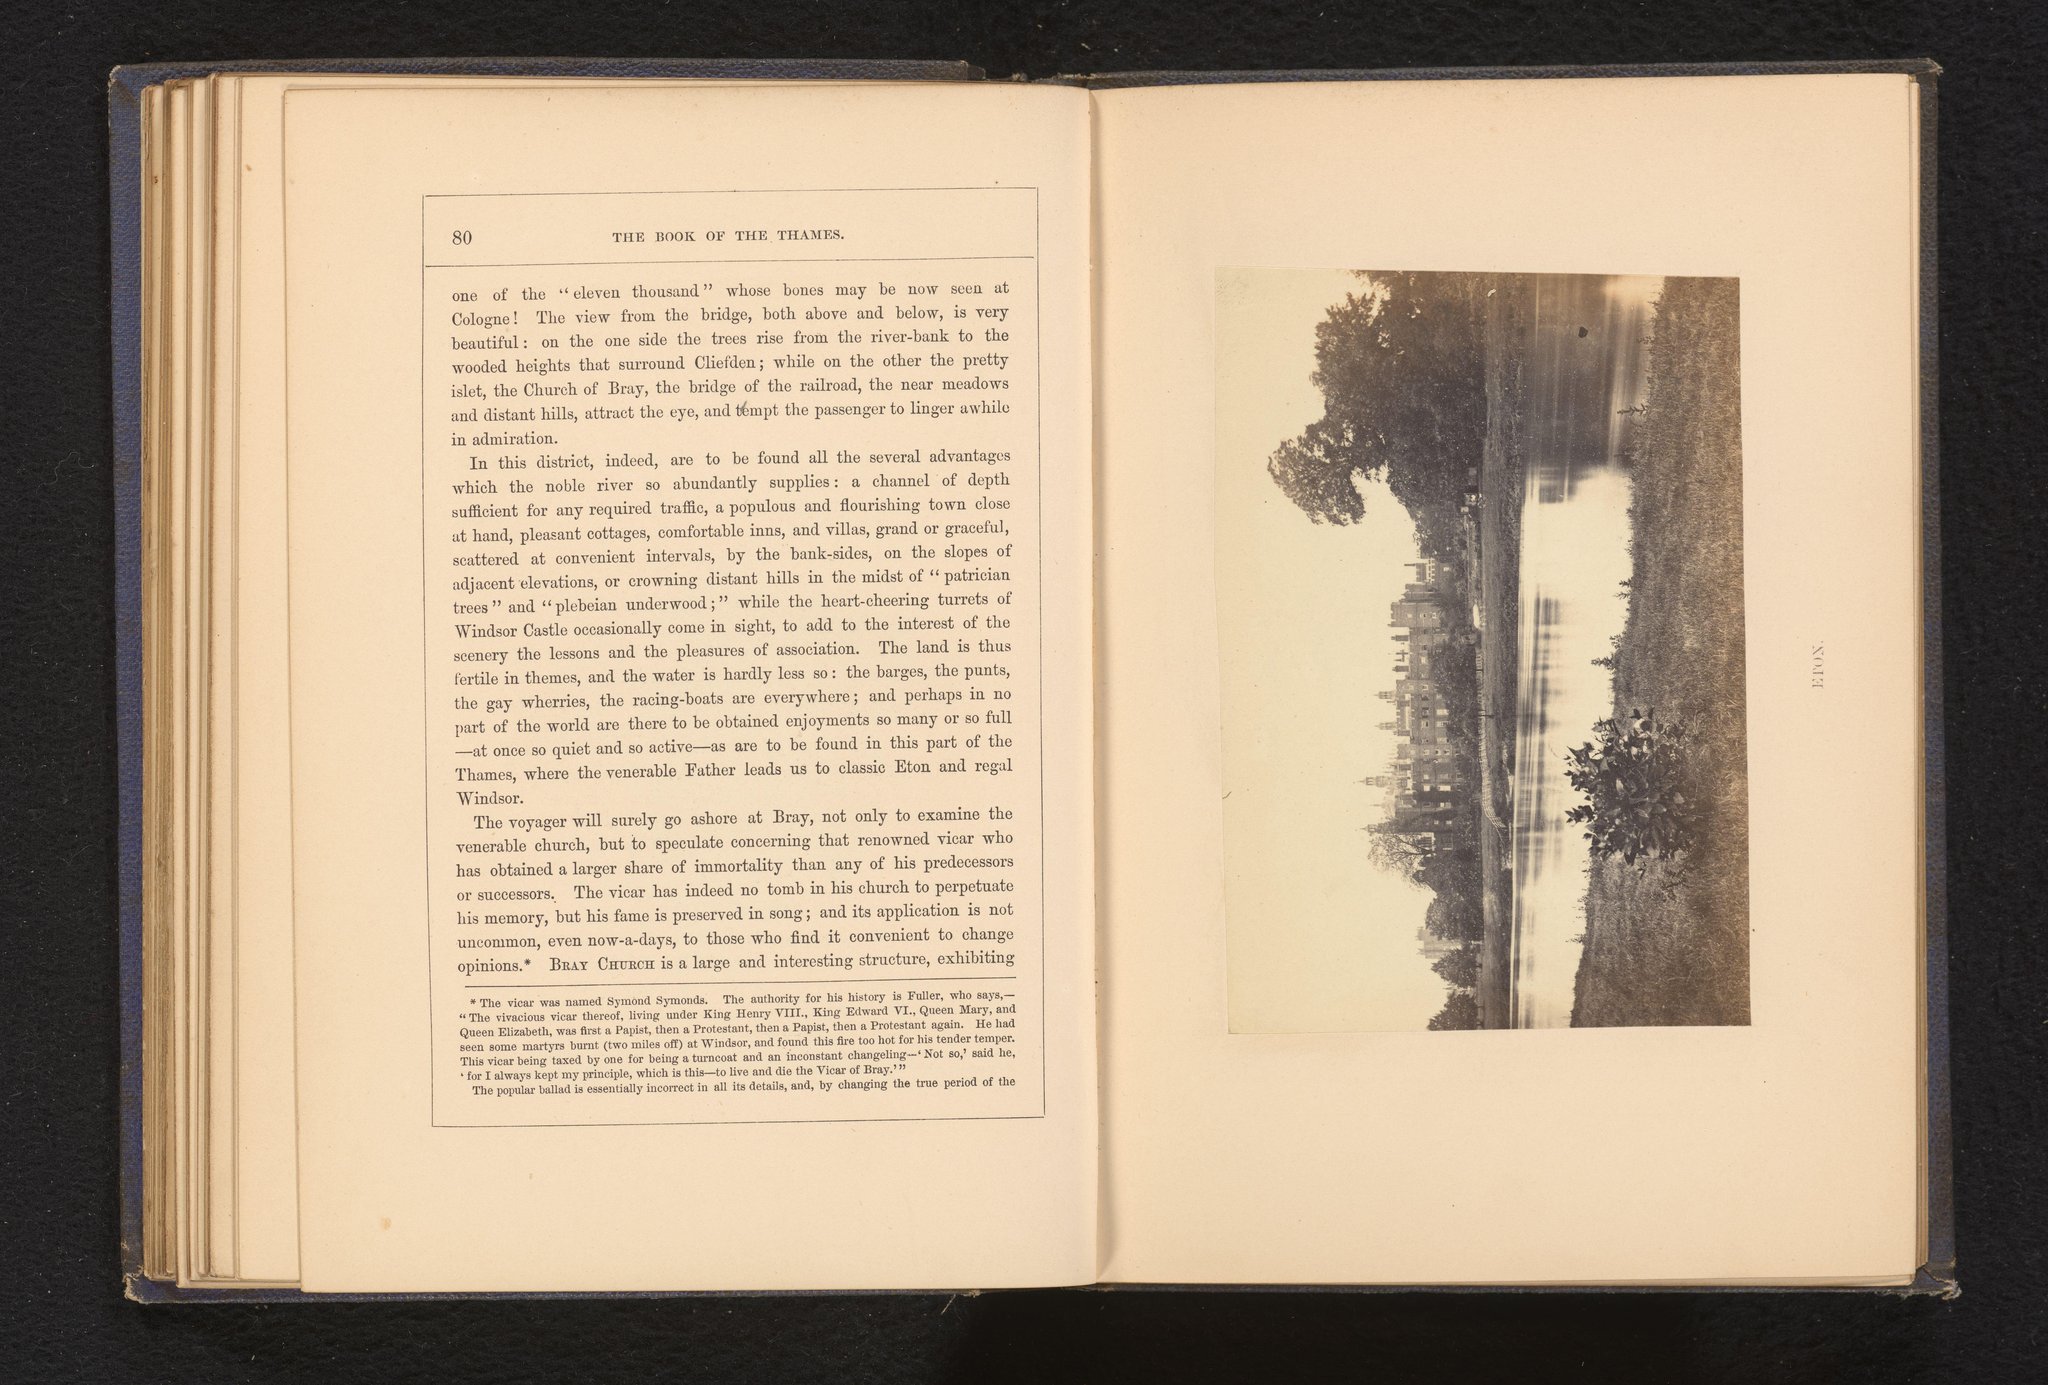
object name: photograph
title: Gezicht over de Theems bij Eton College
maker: francis frith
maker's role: publisher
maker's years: 1822-1898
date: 1862-1867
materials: paper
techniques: albumen print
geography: eton college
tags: river, thames